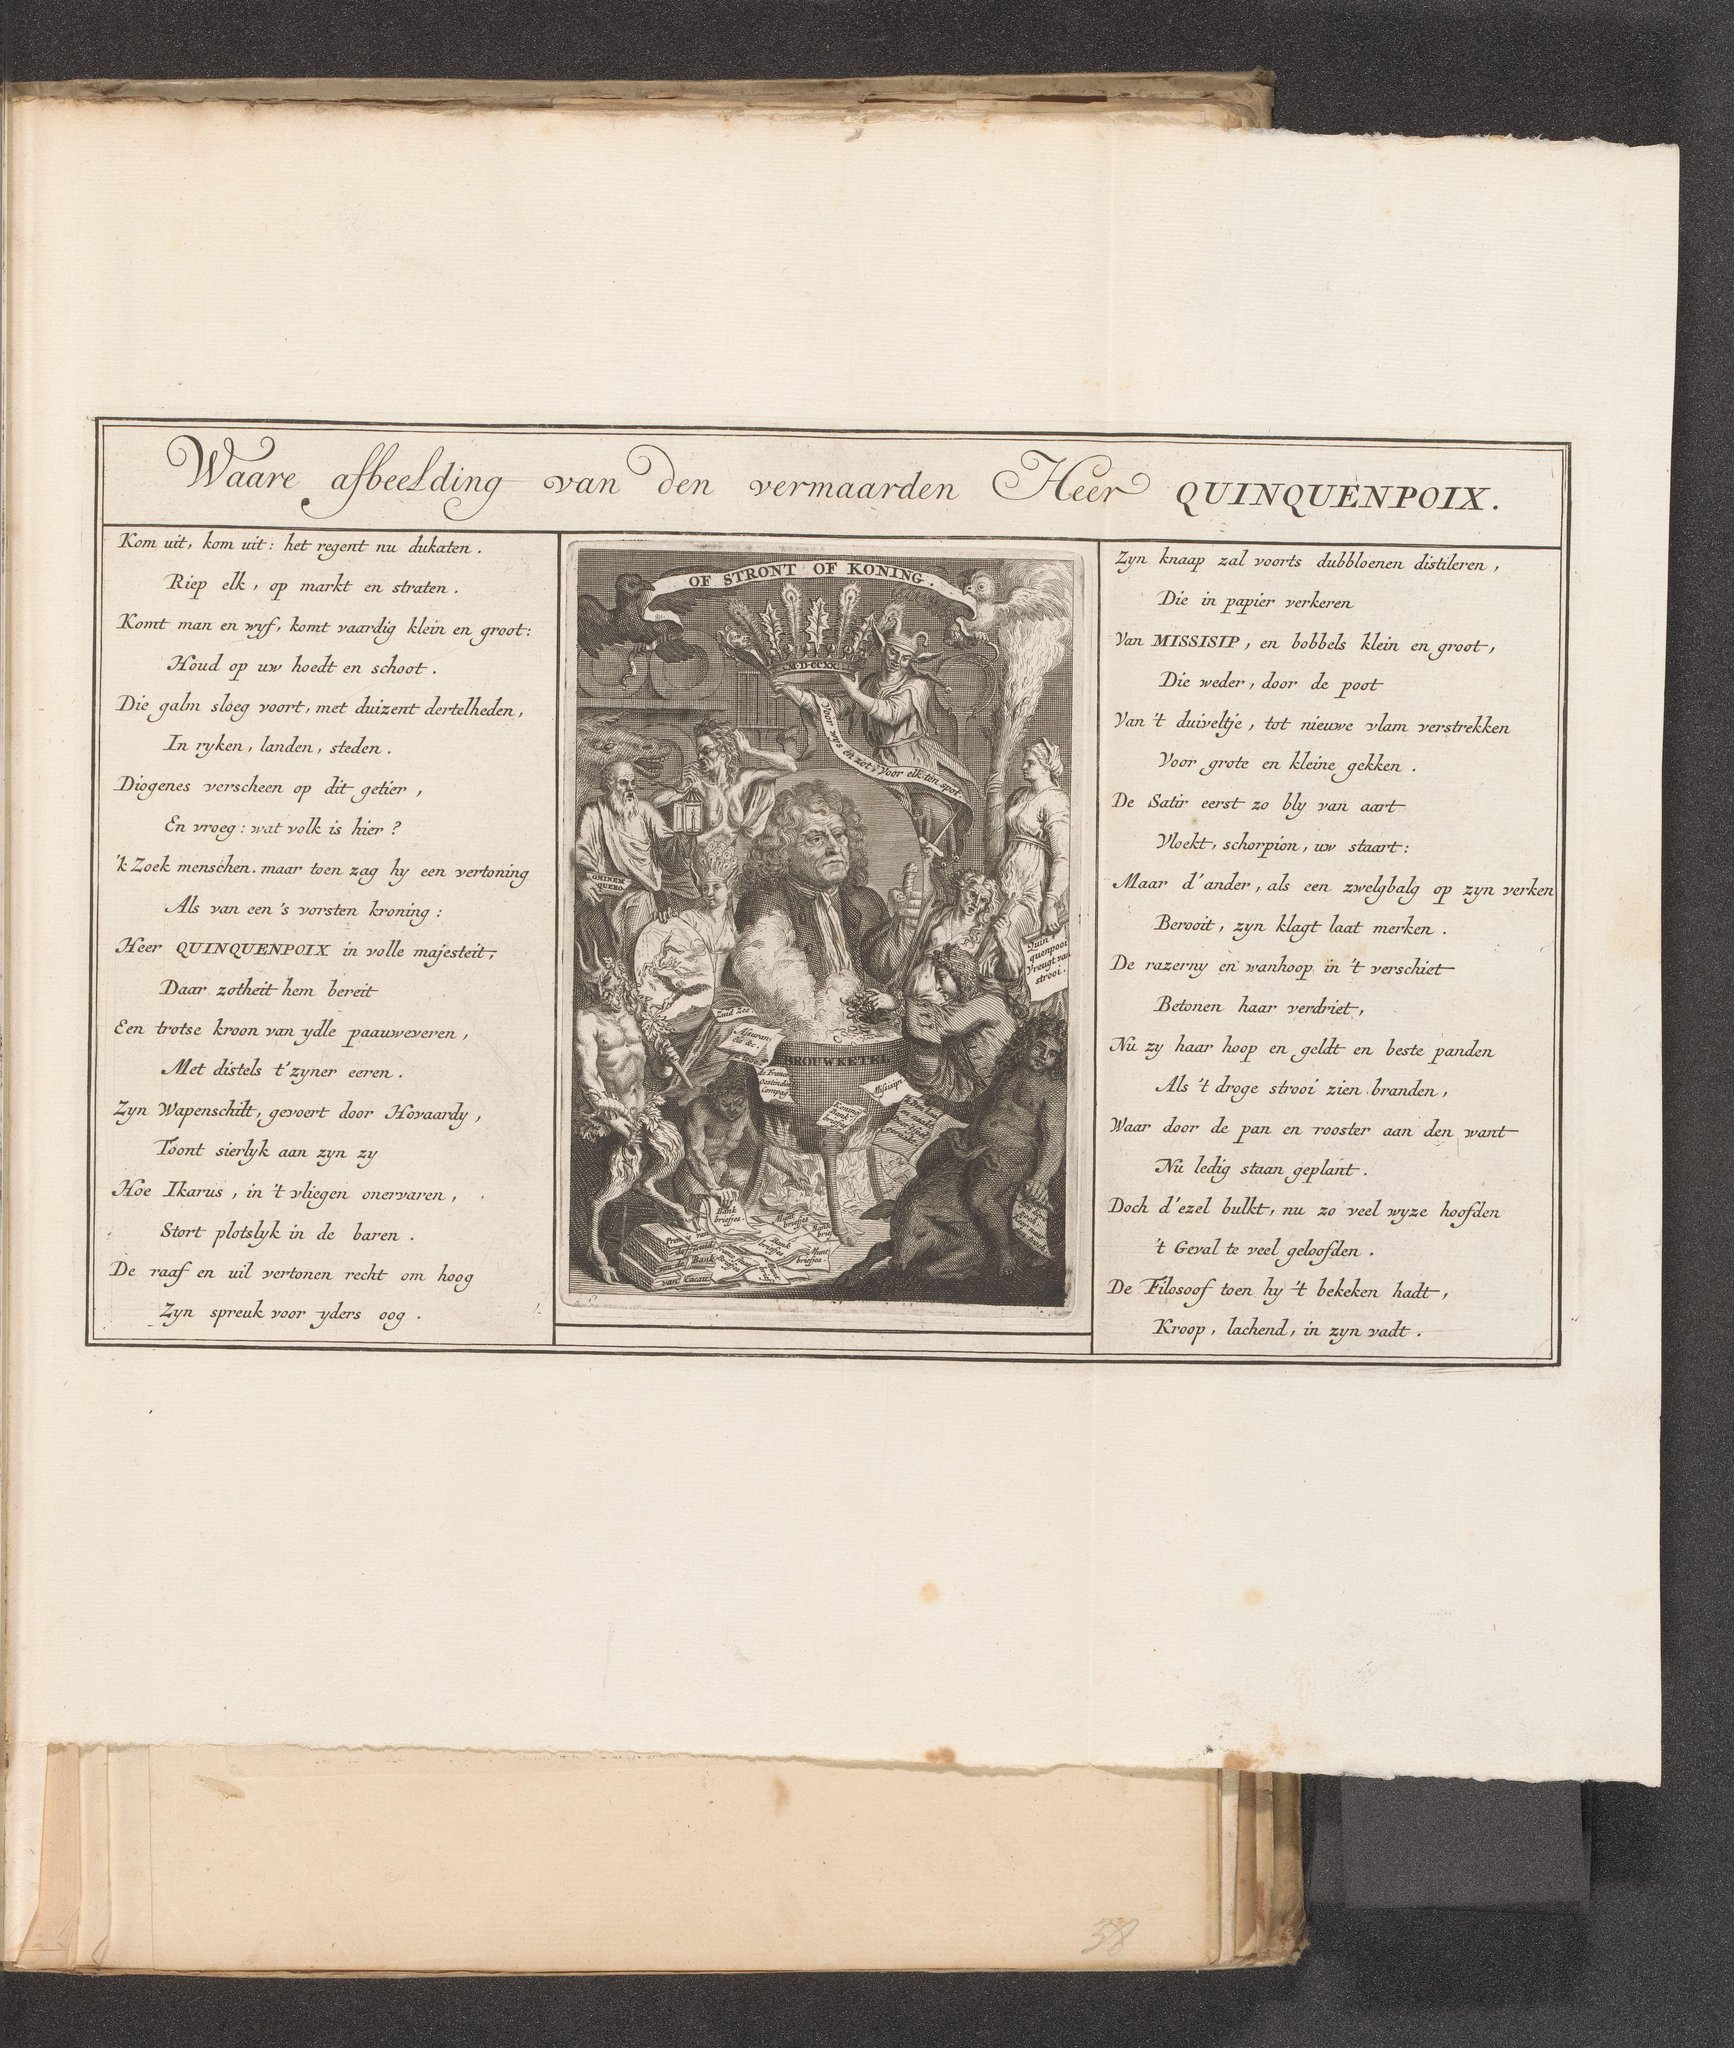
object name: cartoon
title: Het Groote Tafereel der Dwaasheid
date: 1712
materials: paper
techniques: engraving, etching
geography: southern netherlands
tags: brewing, boiling (in a cauldron); witches' kitchen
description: Ware afbeelding van de heer Quinquempoix. Portretmedaillon van John Law als de heer Quinquempoix boven een brouwketel waarin geldstukken worden omgetoverd tot aandelen. Heksenketel met duivels, uilen etc. Boven het portret de Zotheid met een kroon van pauwenveren en hulstbladeren. Hierboven een banderol met: Of Stront of Koning. Deze plaat afgedrukt binnen een grotere plaat met titel en verzen in het Nederlands aan weerszijden. Prent in de gebonden eerste uitgave (304 B 10) van Het Groote Tafereel der Dwaasheid met spotprenten op de Windhandel of Actiehandel van 1720.